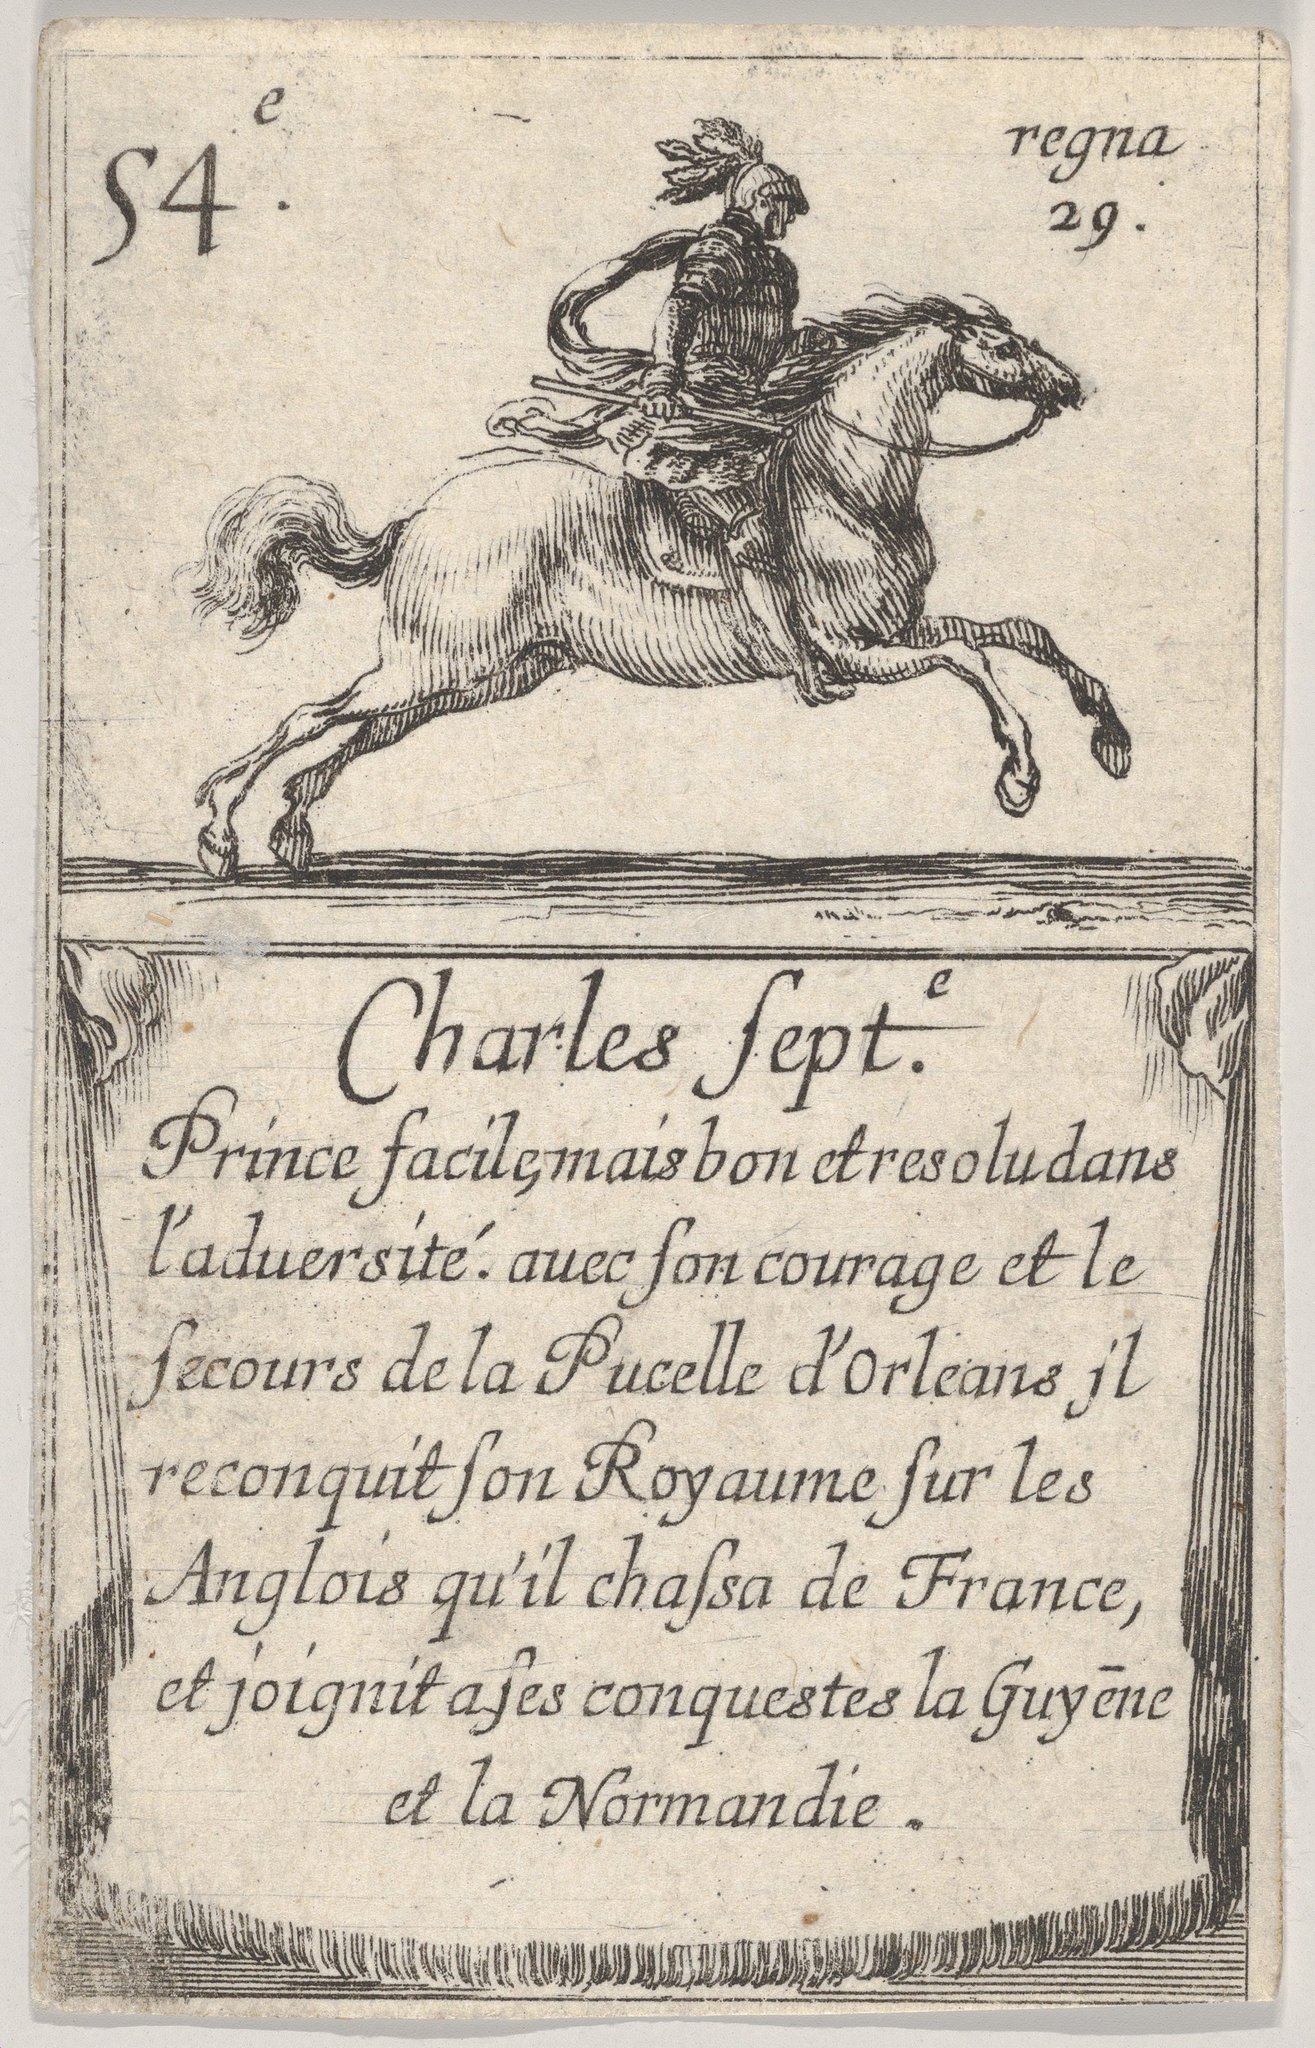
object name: print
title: Charles Sept.-e / Prince facile..., from "Game of the Kings of France" (Jeu des Rois de France)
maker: stefano della bella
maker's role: artist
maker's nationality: italian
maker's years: 1610-1664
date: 1644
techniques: etching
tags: soldiers,horses